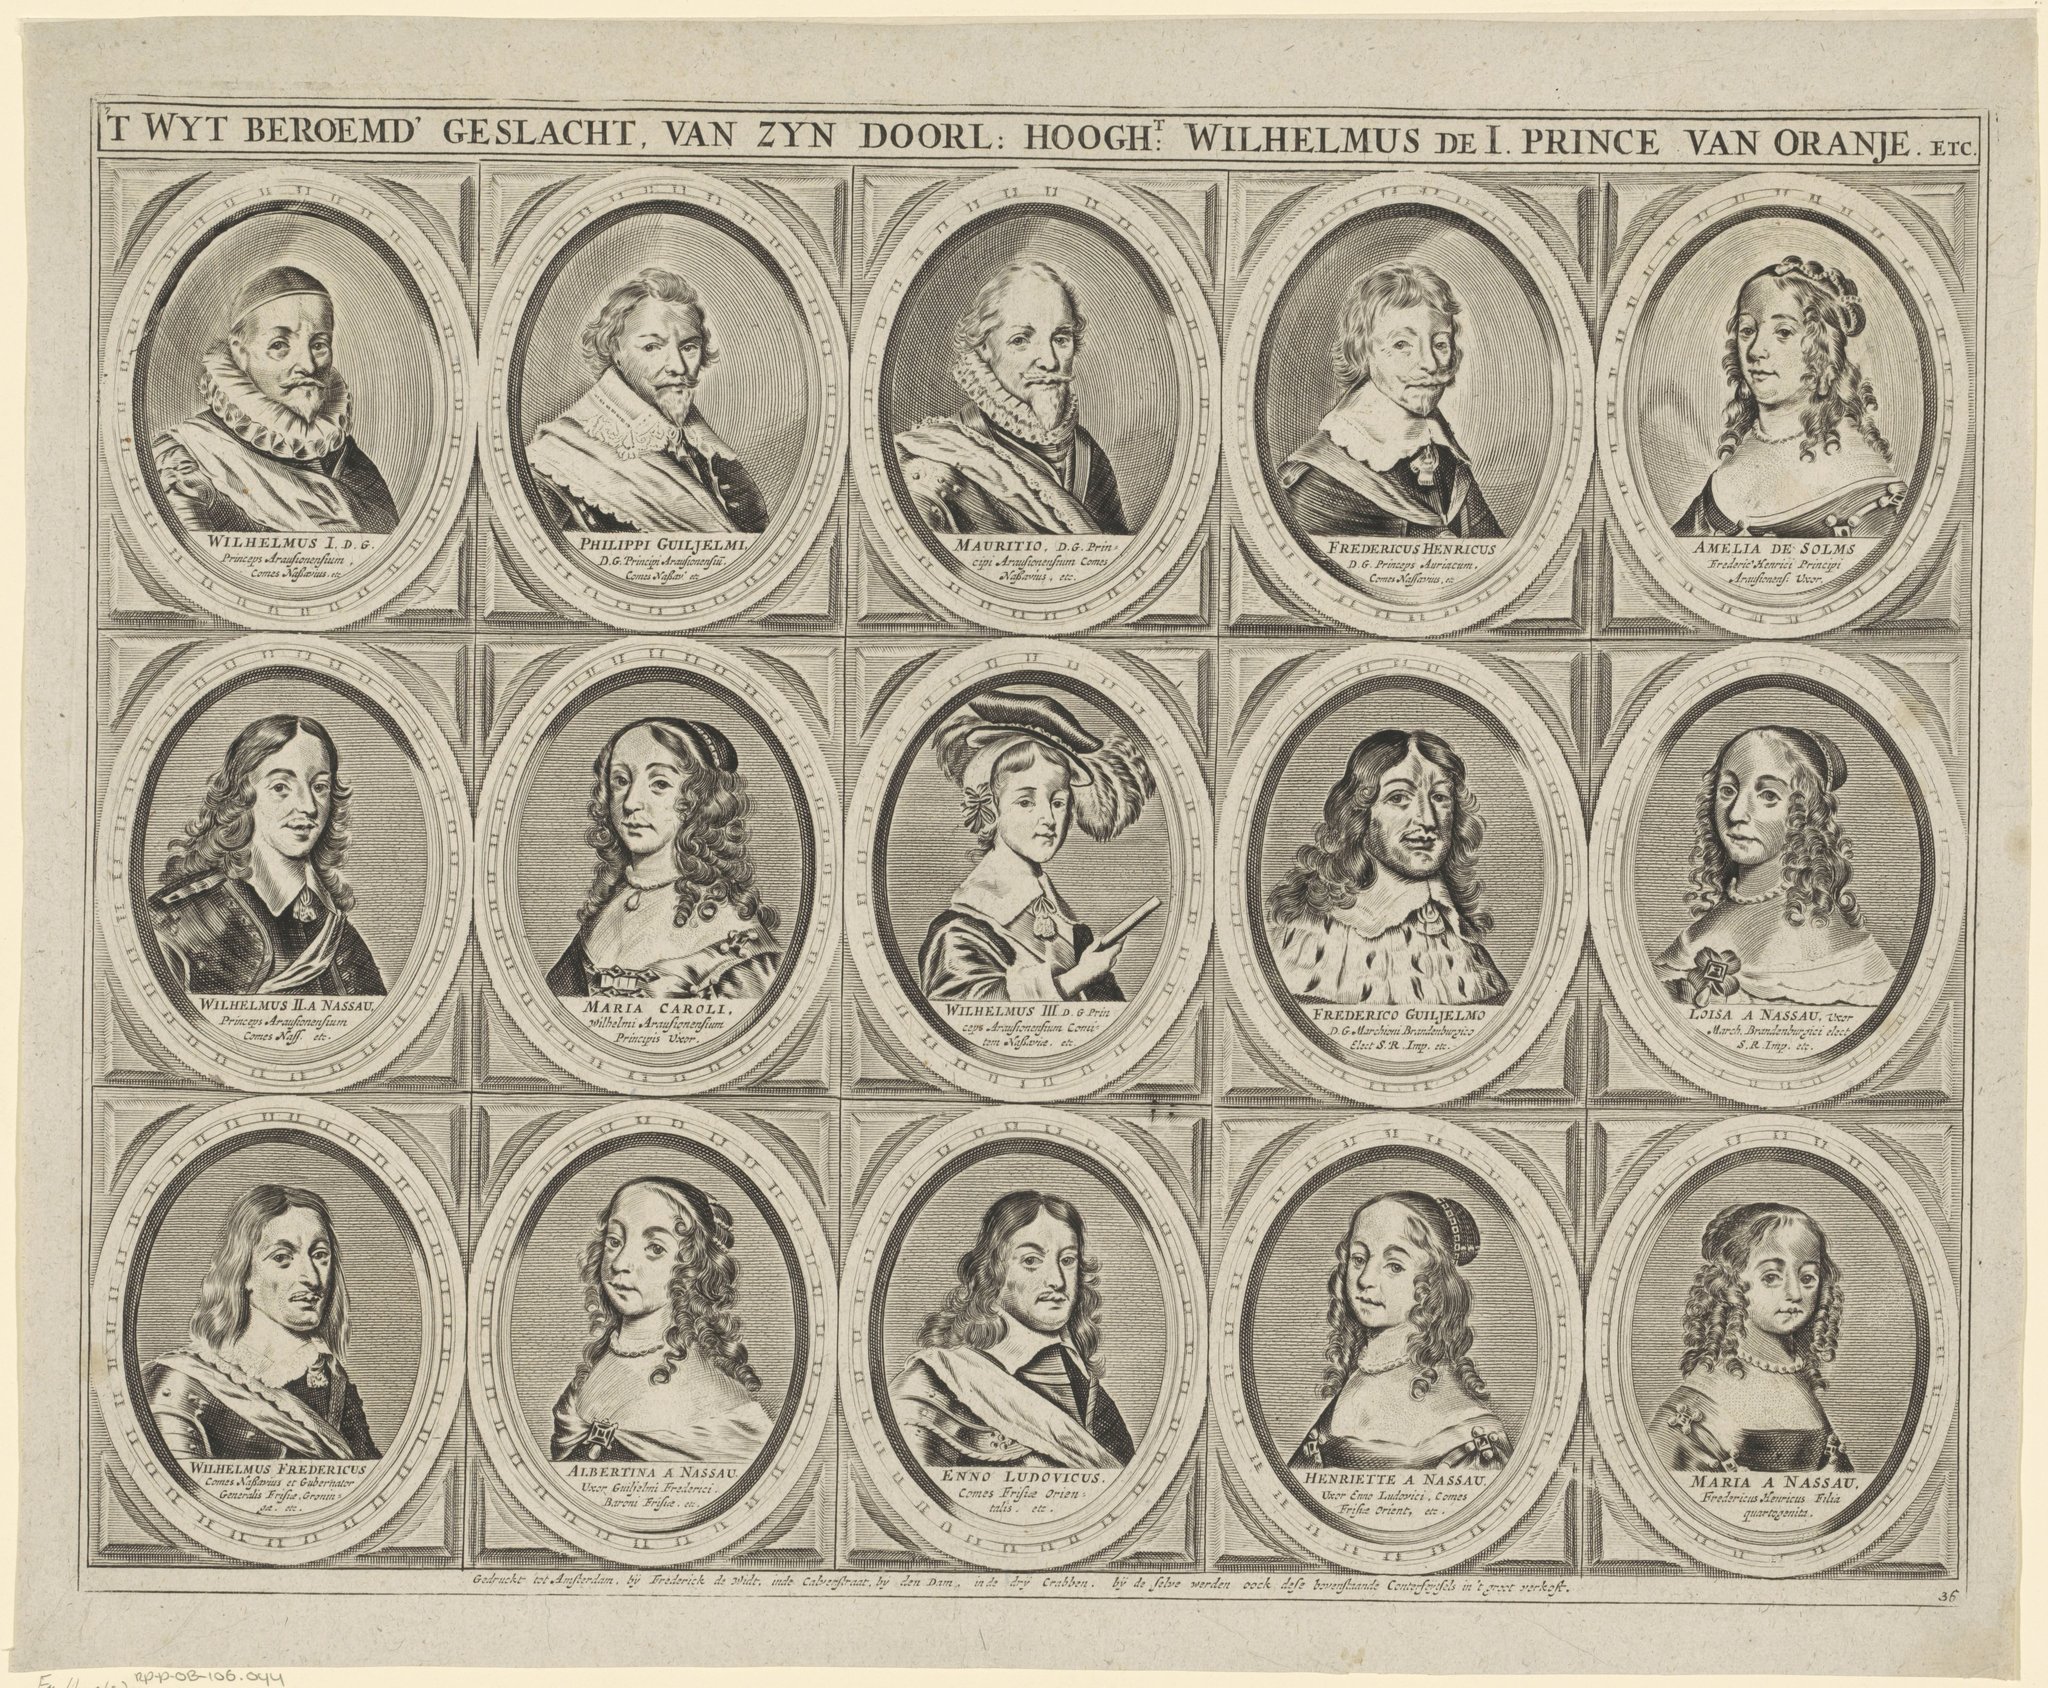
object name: print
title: Portretten van Willem I, prins van Oranje, zijn zoons Filips Willem, Maurits en Frederik Hendrik, prinsen van Oranje, Amalia van Solms, hun zoon met echtgenote, hun dochters met echtgenoten, en een kleinkind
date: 1645-1706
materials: paper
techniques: engraving, etching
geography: amsterdam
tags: arnhem, william iii (prince of orange and king of england, scotland, and ireland), frederick henry (prince of orange), william ii (prince of orange), delft, william i (prince of orange), the hague, maurice (prince of orange), amalia of solms-braunfels, berlin, frederik willem van brandenburg (i), louise henriëtte (prinses van oranje), buren, filips willem (prins van oranje), henriëtte catharina (prinses van oranje), london, mary henrietta stuart, maria (prinses van oranje) (1642-1688), albertine agnes (prinses van oranje)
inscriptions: collector's mark: Lugt 963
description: Portretten van Willem I, zijn zoons Filips Willem, Maurits en Frederik Hendrik, Amalia, hun zoon Willem II met echtgenote Maria Henrietta en hun zoon Willem III, hun dochter Louise Henriëtte met echtgenoot Frederik Willem, hun dochter Albertine Agnes met echtgenoot Willem Frederik, hun dochter Henriëtte Catharina met verloofde Enno Lodewijk, en hun dochter Maria. Elk in een geornamenteerd ovaal met in een kader hun namen en titels. In de bovenmarge een regel Nederlandse tekst.